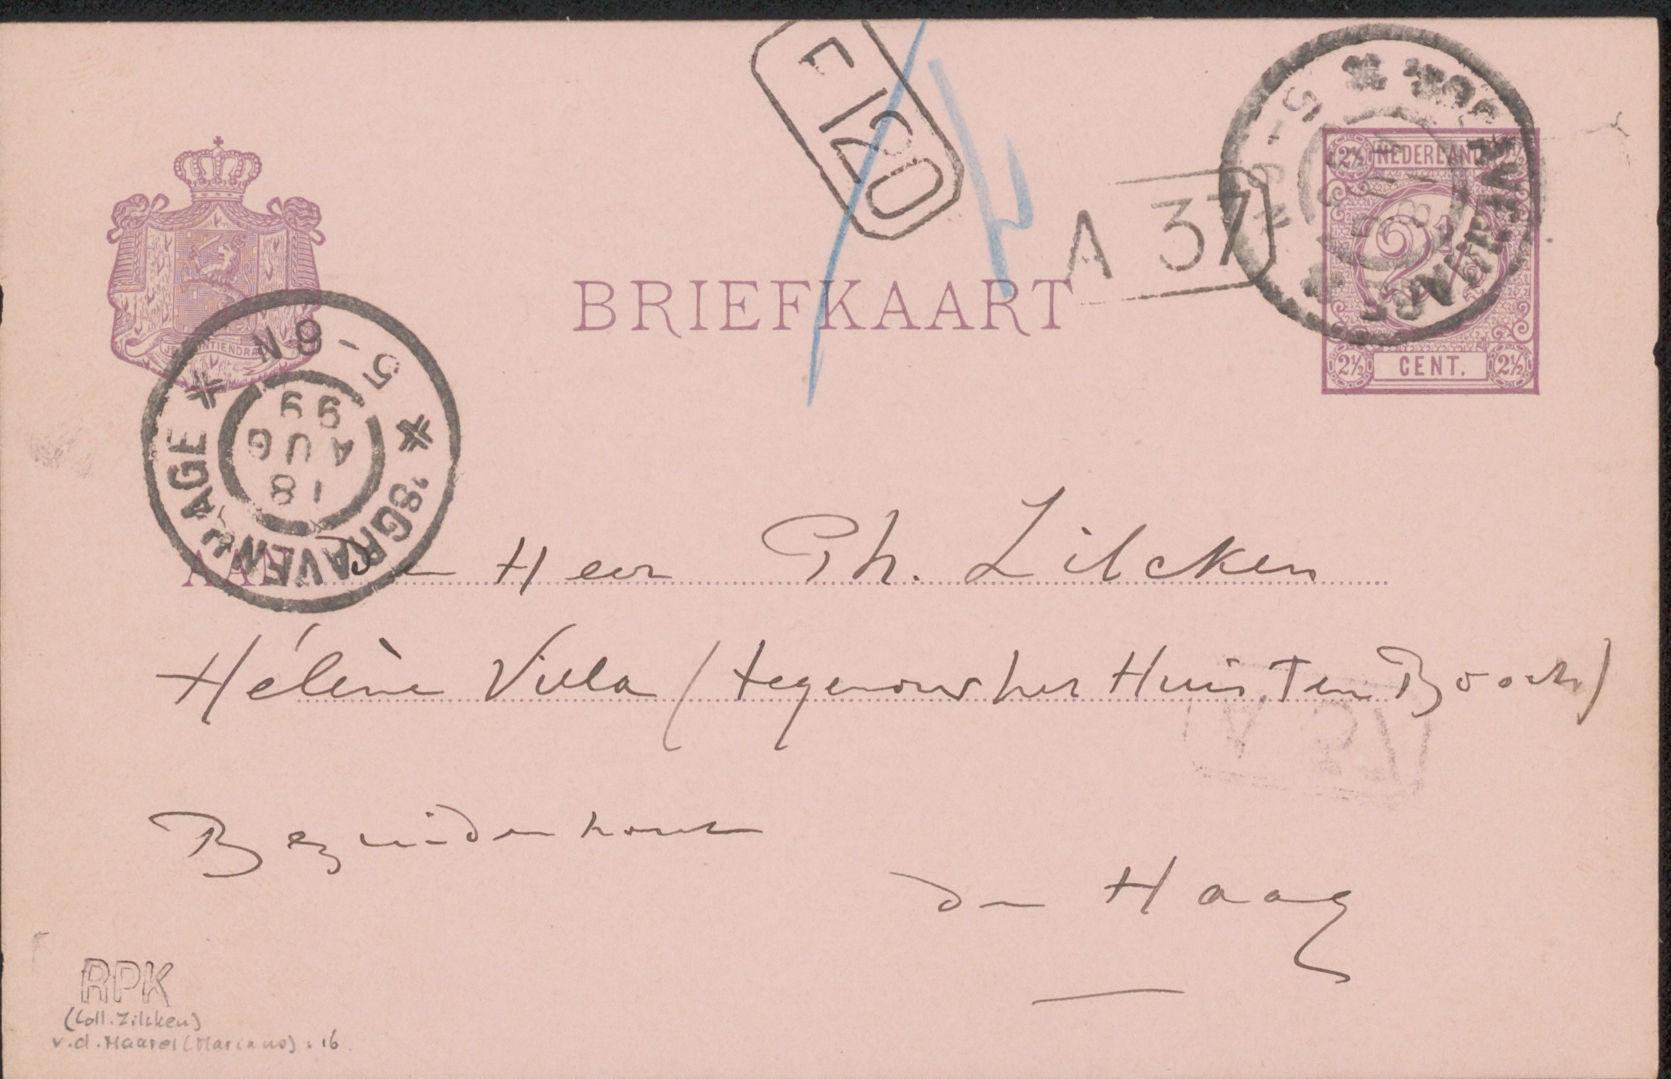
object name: postcard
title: Briefkaart aan Philip Zilcken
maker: marinus van der maarel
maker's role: draughtsman, painter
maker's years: 1857-1921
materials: cardboard, ink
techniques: pen, writing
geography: the hague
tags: painter, draughtsman, philip zilcken, the graphic arts, painting (including book-illumination, miniature-painting), historical persons (portraits and scenes from the life), printed matter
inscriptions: collector's mark: ‘RPK’